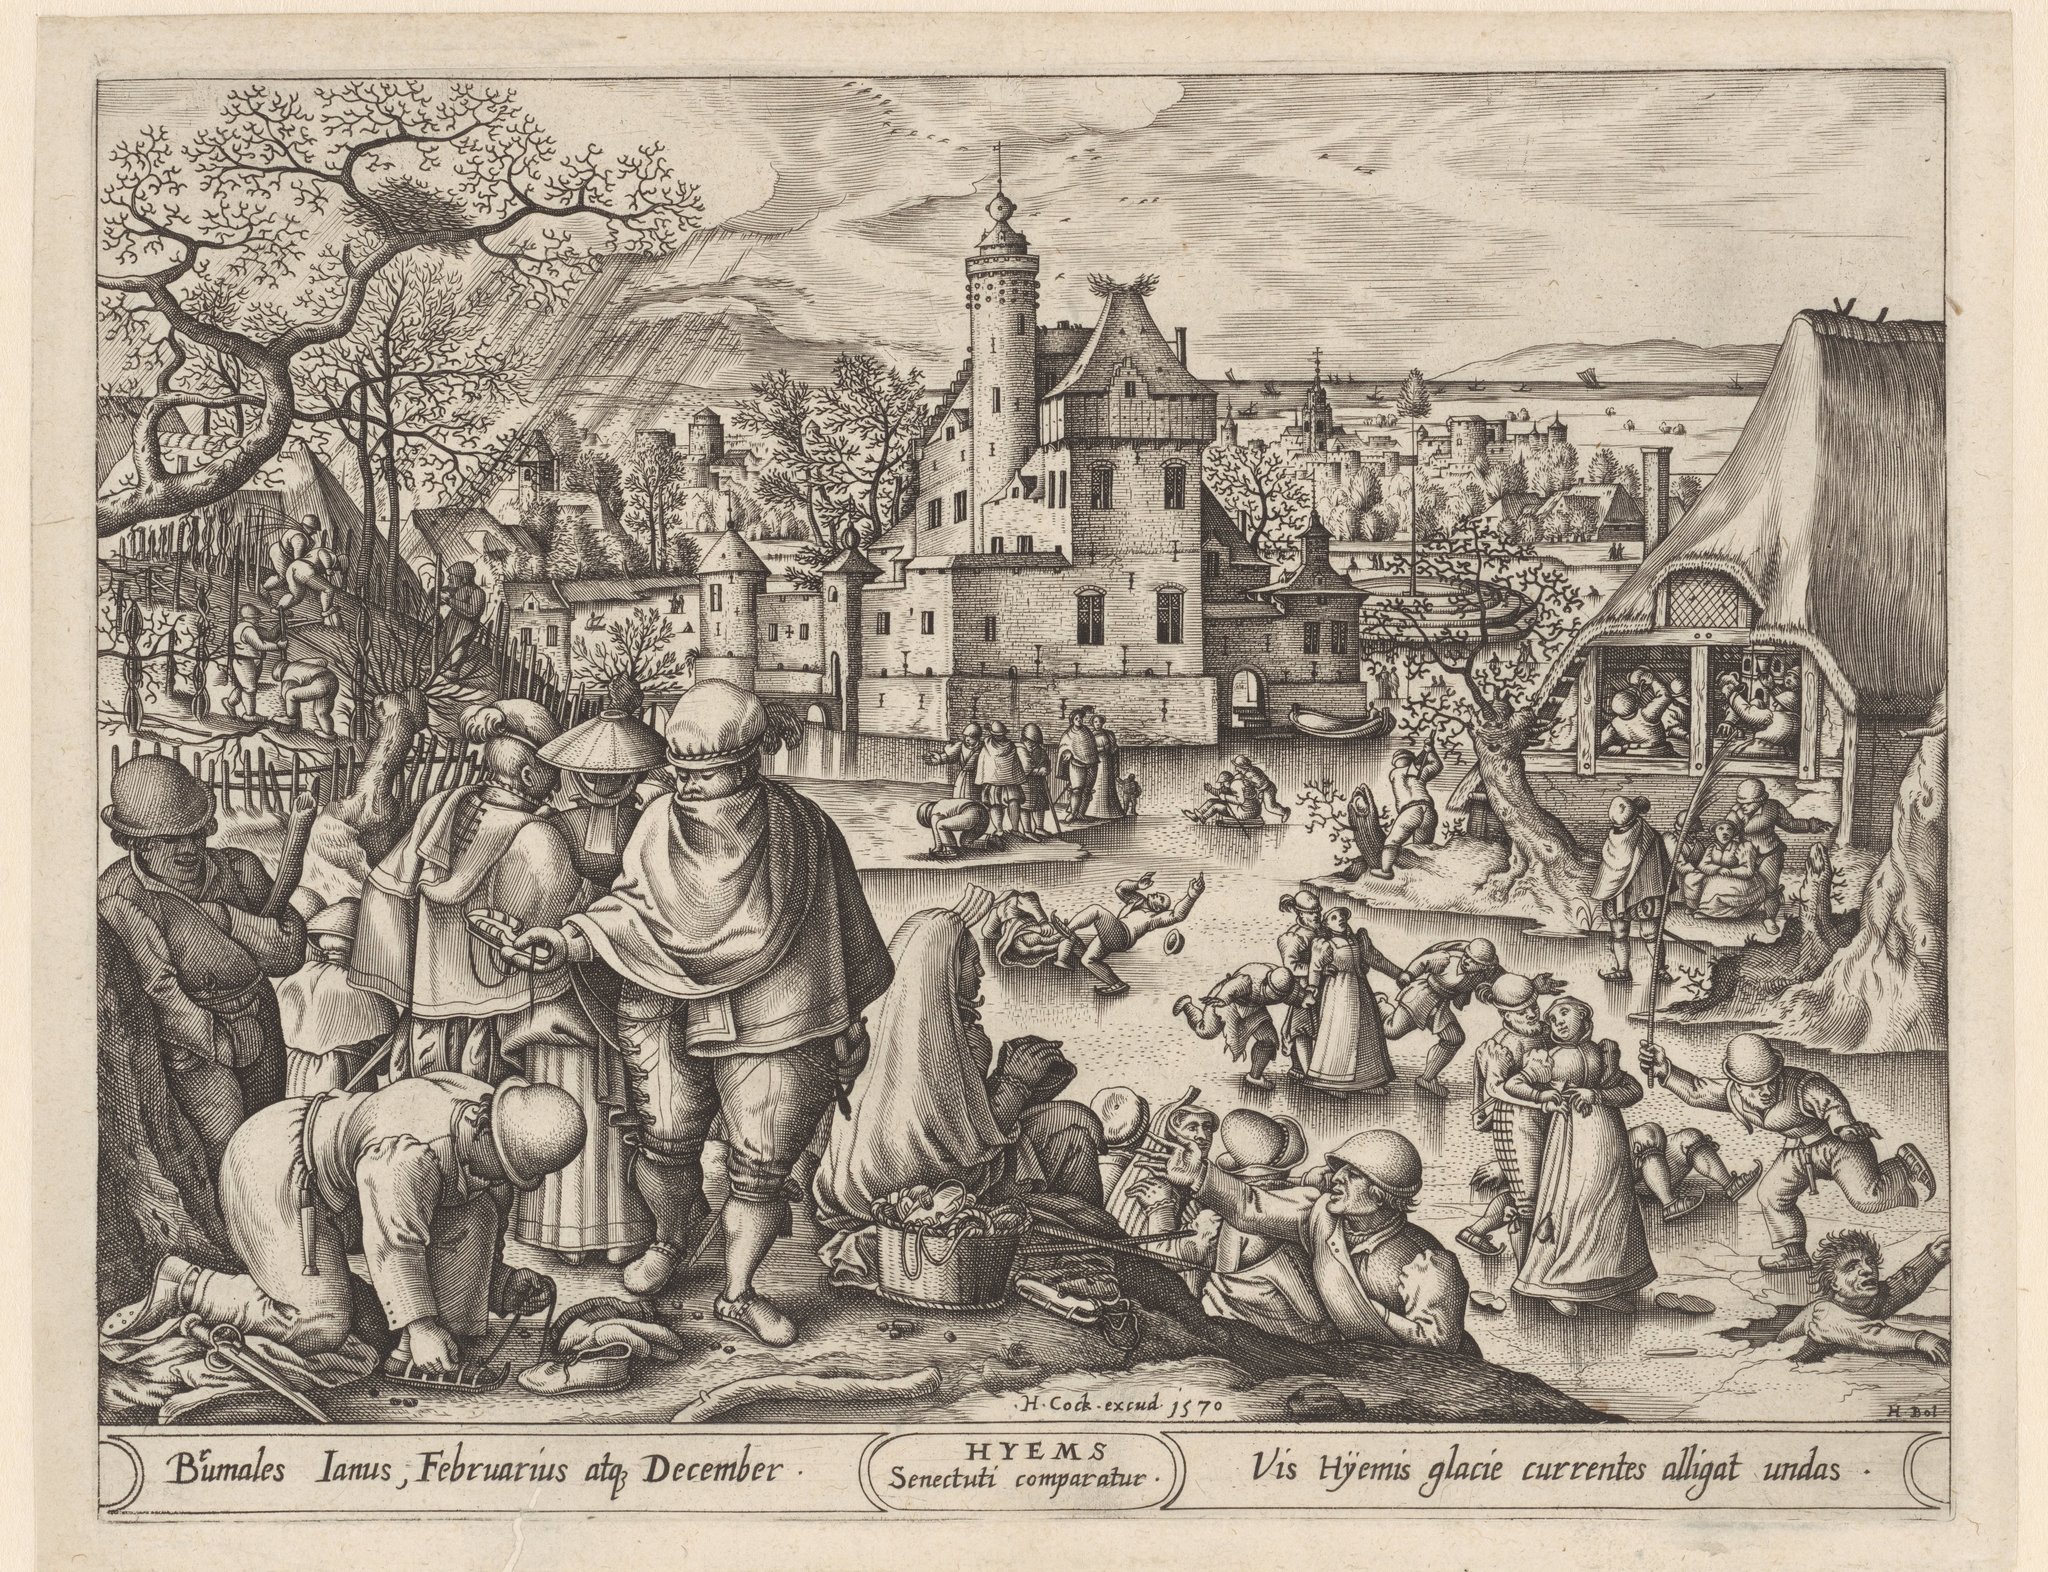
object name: print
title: De vier seizoenen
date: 1570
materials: paper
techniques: engraving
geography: antwerp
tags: winter ~ human activities (the four seasons of the year), winter landscape; landscape symbolizing winter (the four seasons of the year), skates (winter sports), the four seasons of the year ~ human activities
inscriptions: collector's mark: Lugt 2228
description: In een weids landschap verrichten dorpelingen bezigheden die horen bij de maanden december, januari en februari. Bij een kasteel wordt plezier gemaakt op het ijs. Onder de voorstelling de titel met aan weerszijden daarvan twee regels in het Latijn. Prent uit een serie van vier prenten met voorstellingen van de vier seizoenen, waarvan twee naar Hans Bol en twee naar Pieter Brueghel I.